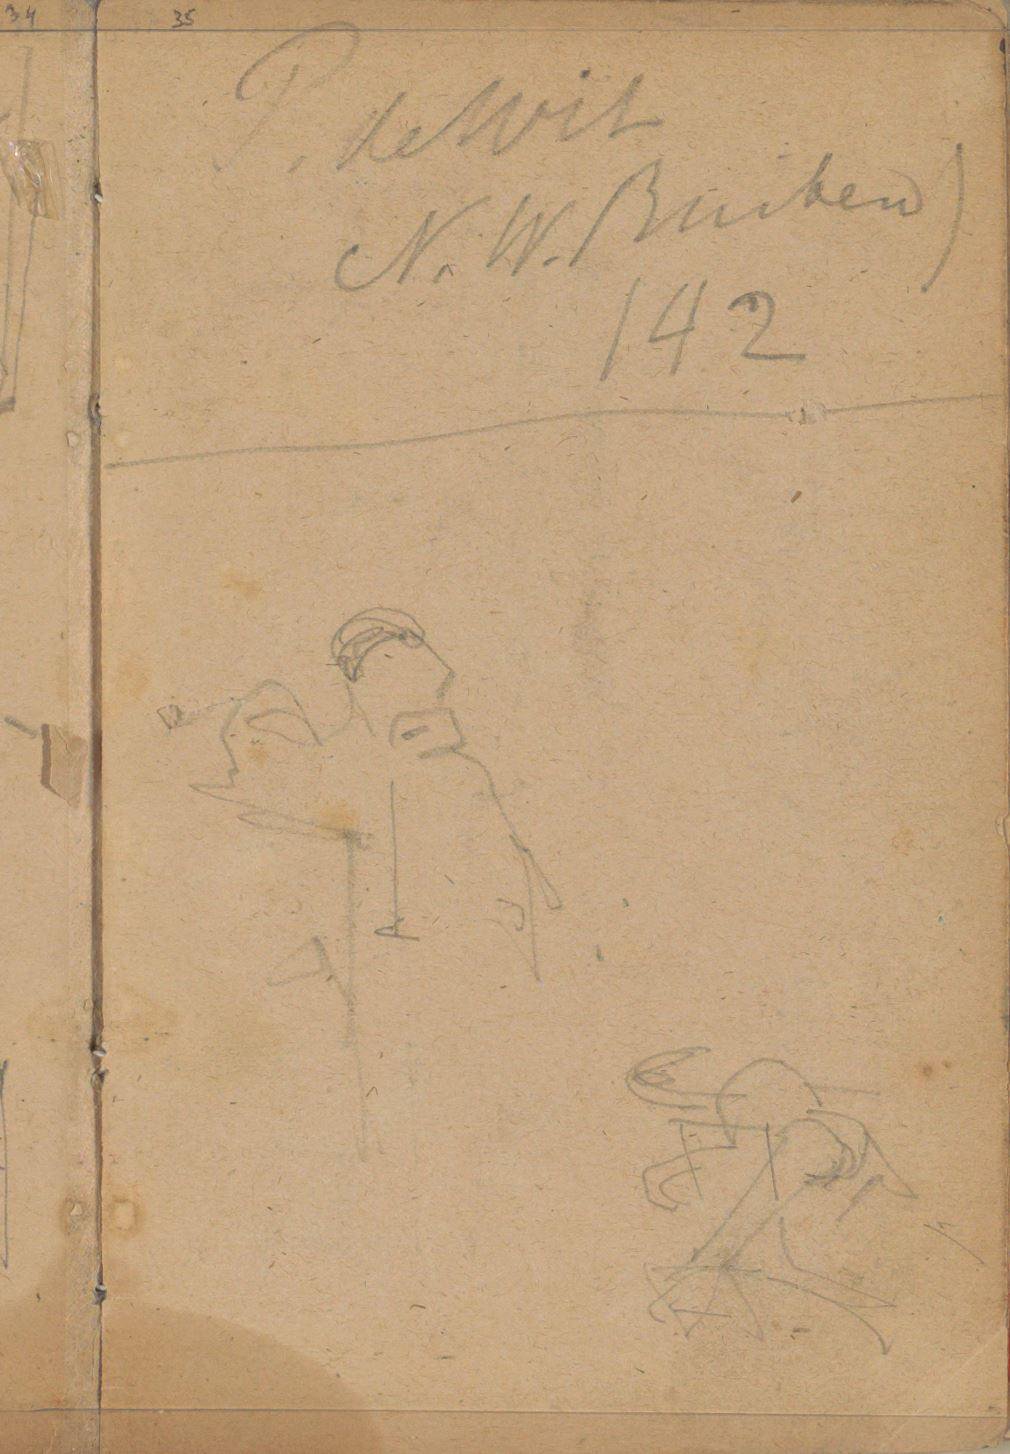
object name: sketchbook leaf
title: Studies, mogelijk van figuren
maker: george hendrik breitner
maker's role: draughtsman, painter, print maker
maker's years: 1857-1923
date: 1881-1883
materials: paper, pencil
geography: south holland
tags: human being, man in general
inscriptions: address: ‘P. de Wit/ N.W. Buiten/ 142’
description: Studies, mogelijk van figuren. Pagina 35 uit een schetsboek met 70 bladen.